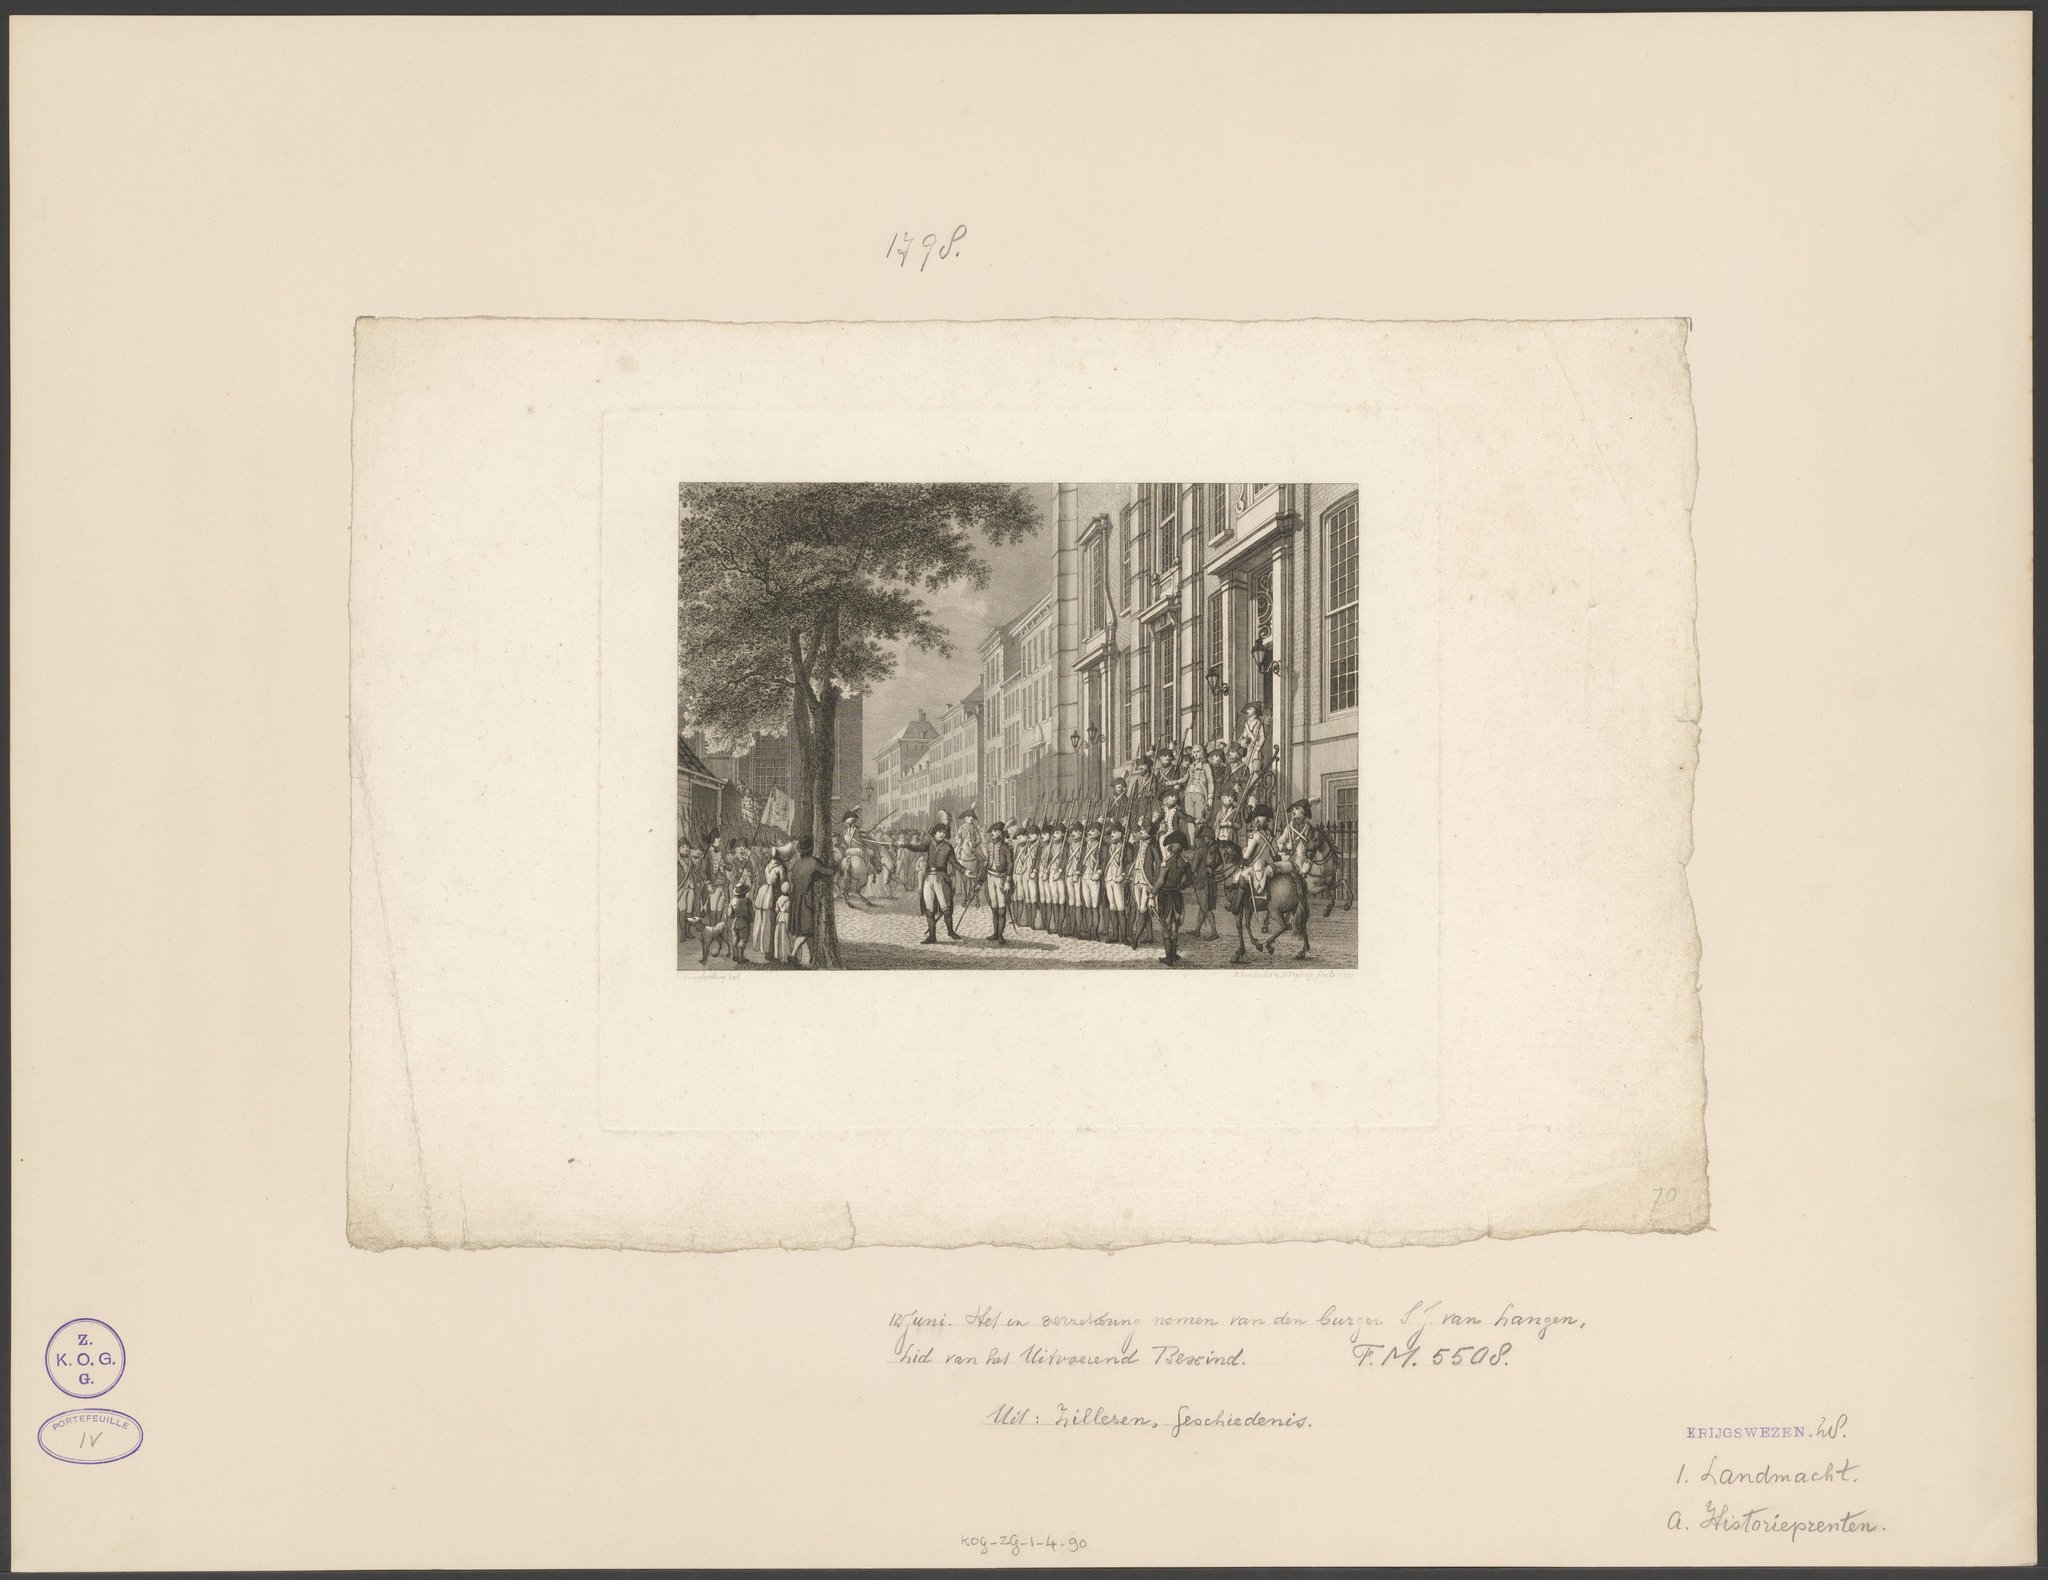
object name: history print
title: Arrestatie van S.J van Langen, 1798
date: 1799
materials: paper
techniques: engraving, etching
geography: northern netherlands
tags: leiden, arrest (of criminal)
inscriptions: collector's mark, collector's mark: Lugt 1641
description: Gebruikt als illustratie in: Cornelis Rogge, Geschiedenis der staatsregeling, voor het Bataafsche volk. Amsterdam: Johannes Allart, 1799, p. 592/593.